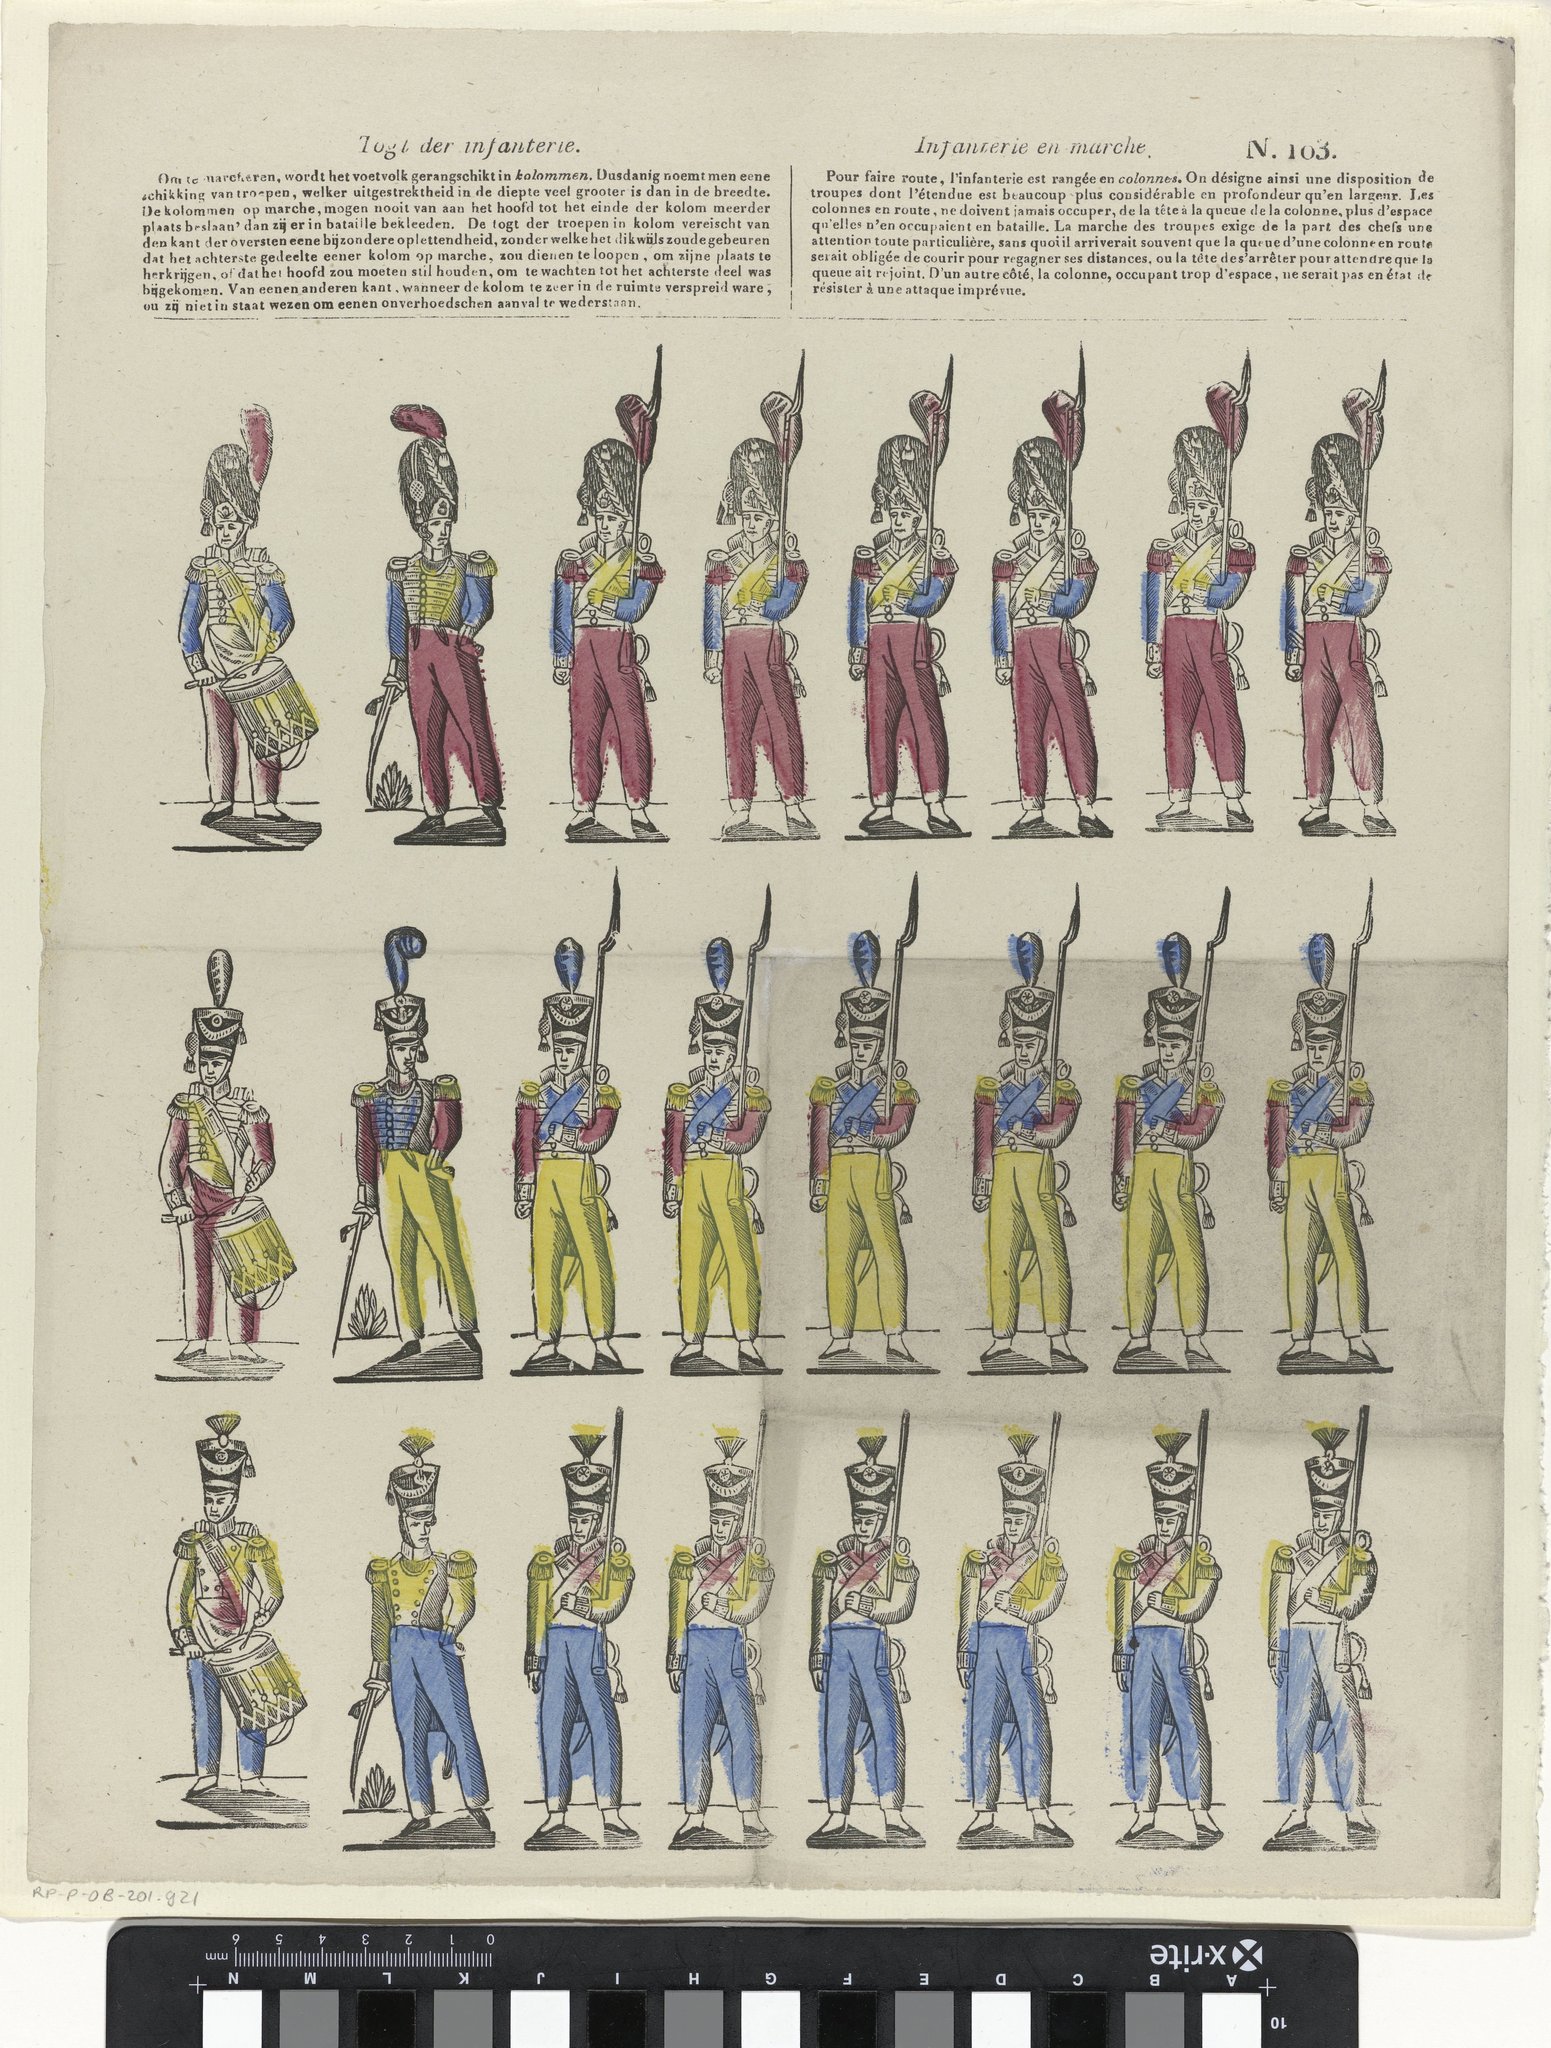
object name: popular print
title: Togt der infanterie / Infanterie en marche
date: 1800-1833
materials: paper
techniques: colour, letterpress printing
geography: turnhout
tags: the soldier; the soldier's life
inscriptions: collector's mark: Lugt 2760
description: Blad met 3 horizontale rijen met voorstellingen van militairen. Onder de titel een bovenschrift in het Frans en in het Nederlands in twee kolommen. Genummerd midden boven: N. 103.